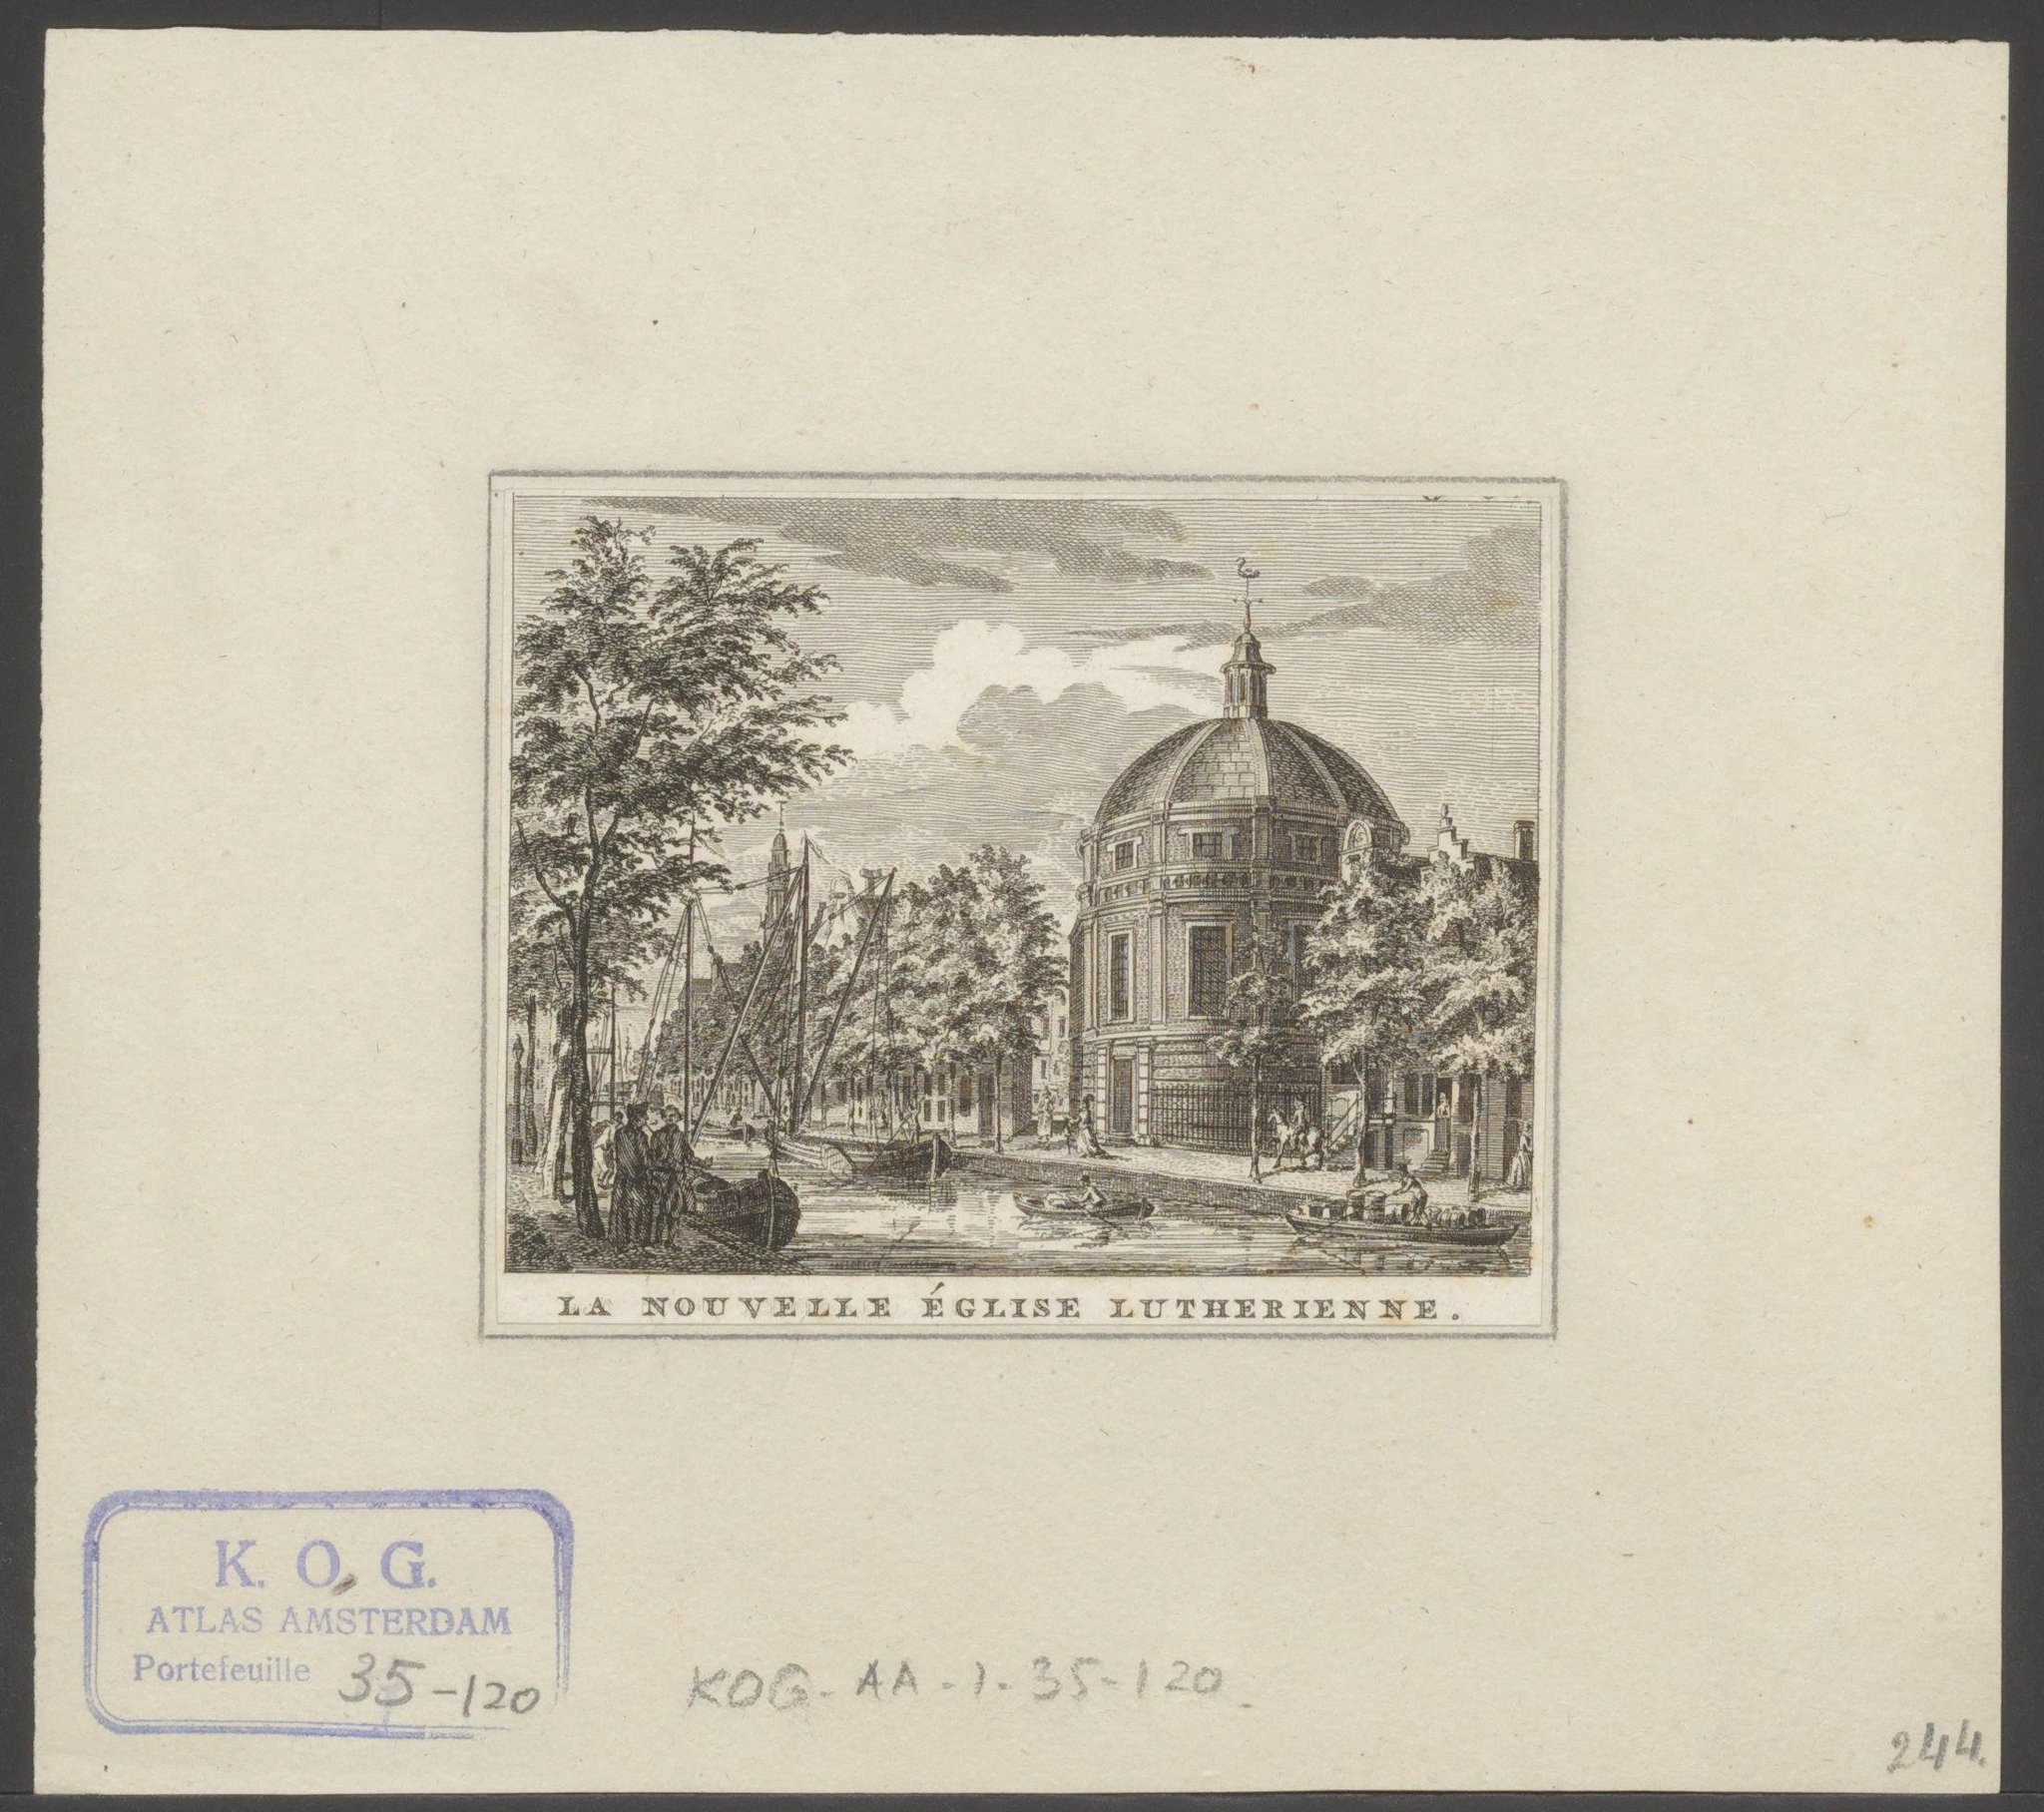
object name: print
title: La nouvelle Église Lutherienne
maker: Anonymous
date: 1793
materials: paper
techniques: engraving, etching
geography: amsterdam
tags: protestant churches and denominations (lutherans), parts of church exterior and annexes: dome, church (exterior), canals, waters (in city) (+ city(-scape) with figures, staffage)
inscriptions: collector's mark: ‘35-120’ Lugt 1641b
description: Prent uit: Le Guide d'Amsterdam, avec la Description de Tout ce qu'il ya a de Plus Interessant. Amsterdam: Cornelis Covens, 1793. Of uit latere editie van 1802.